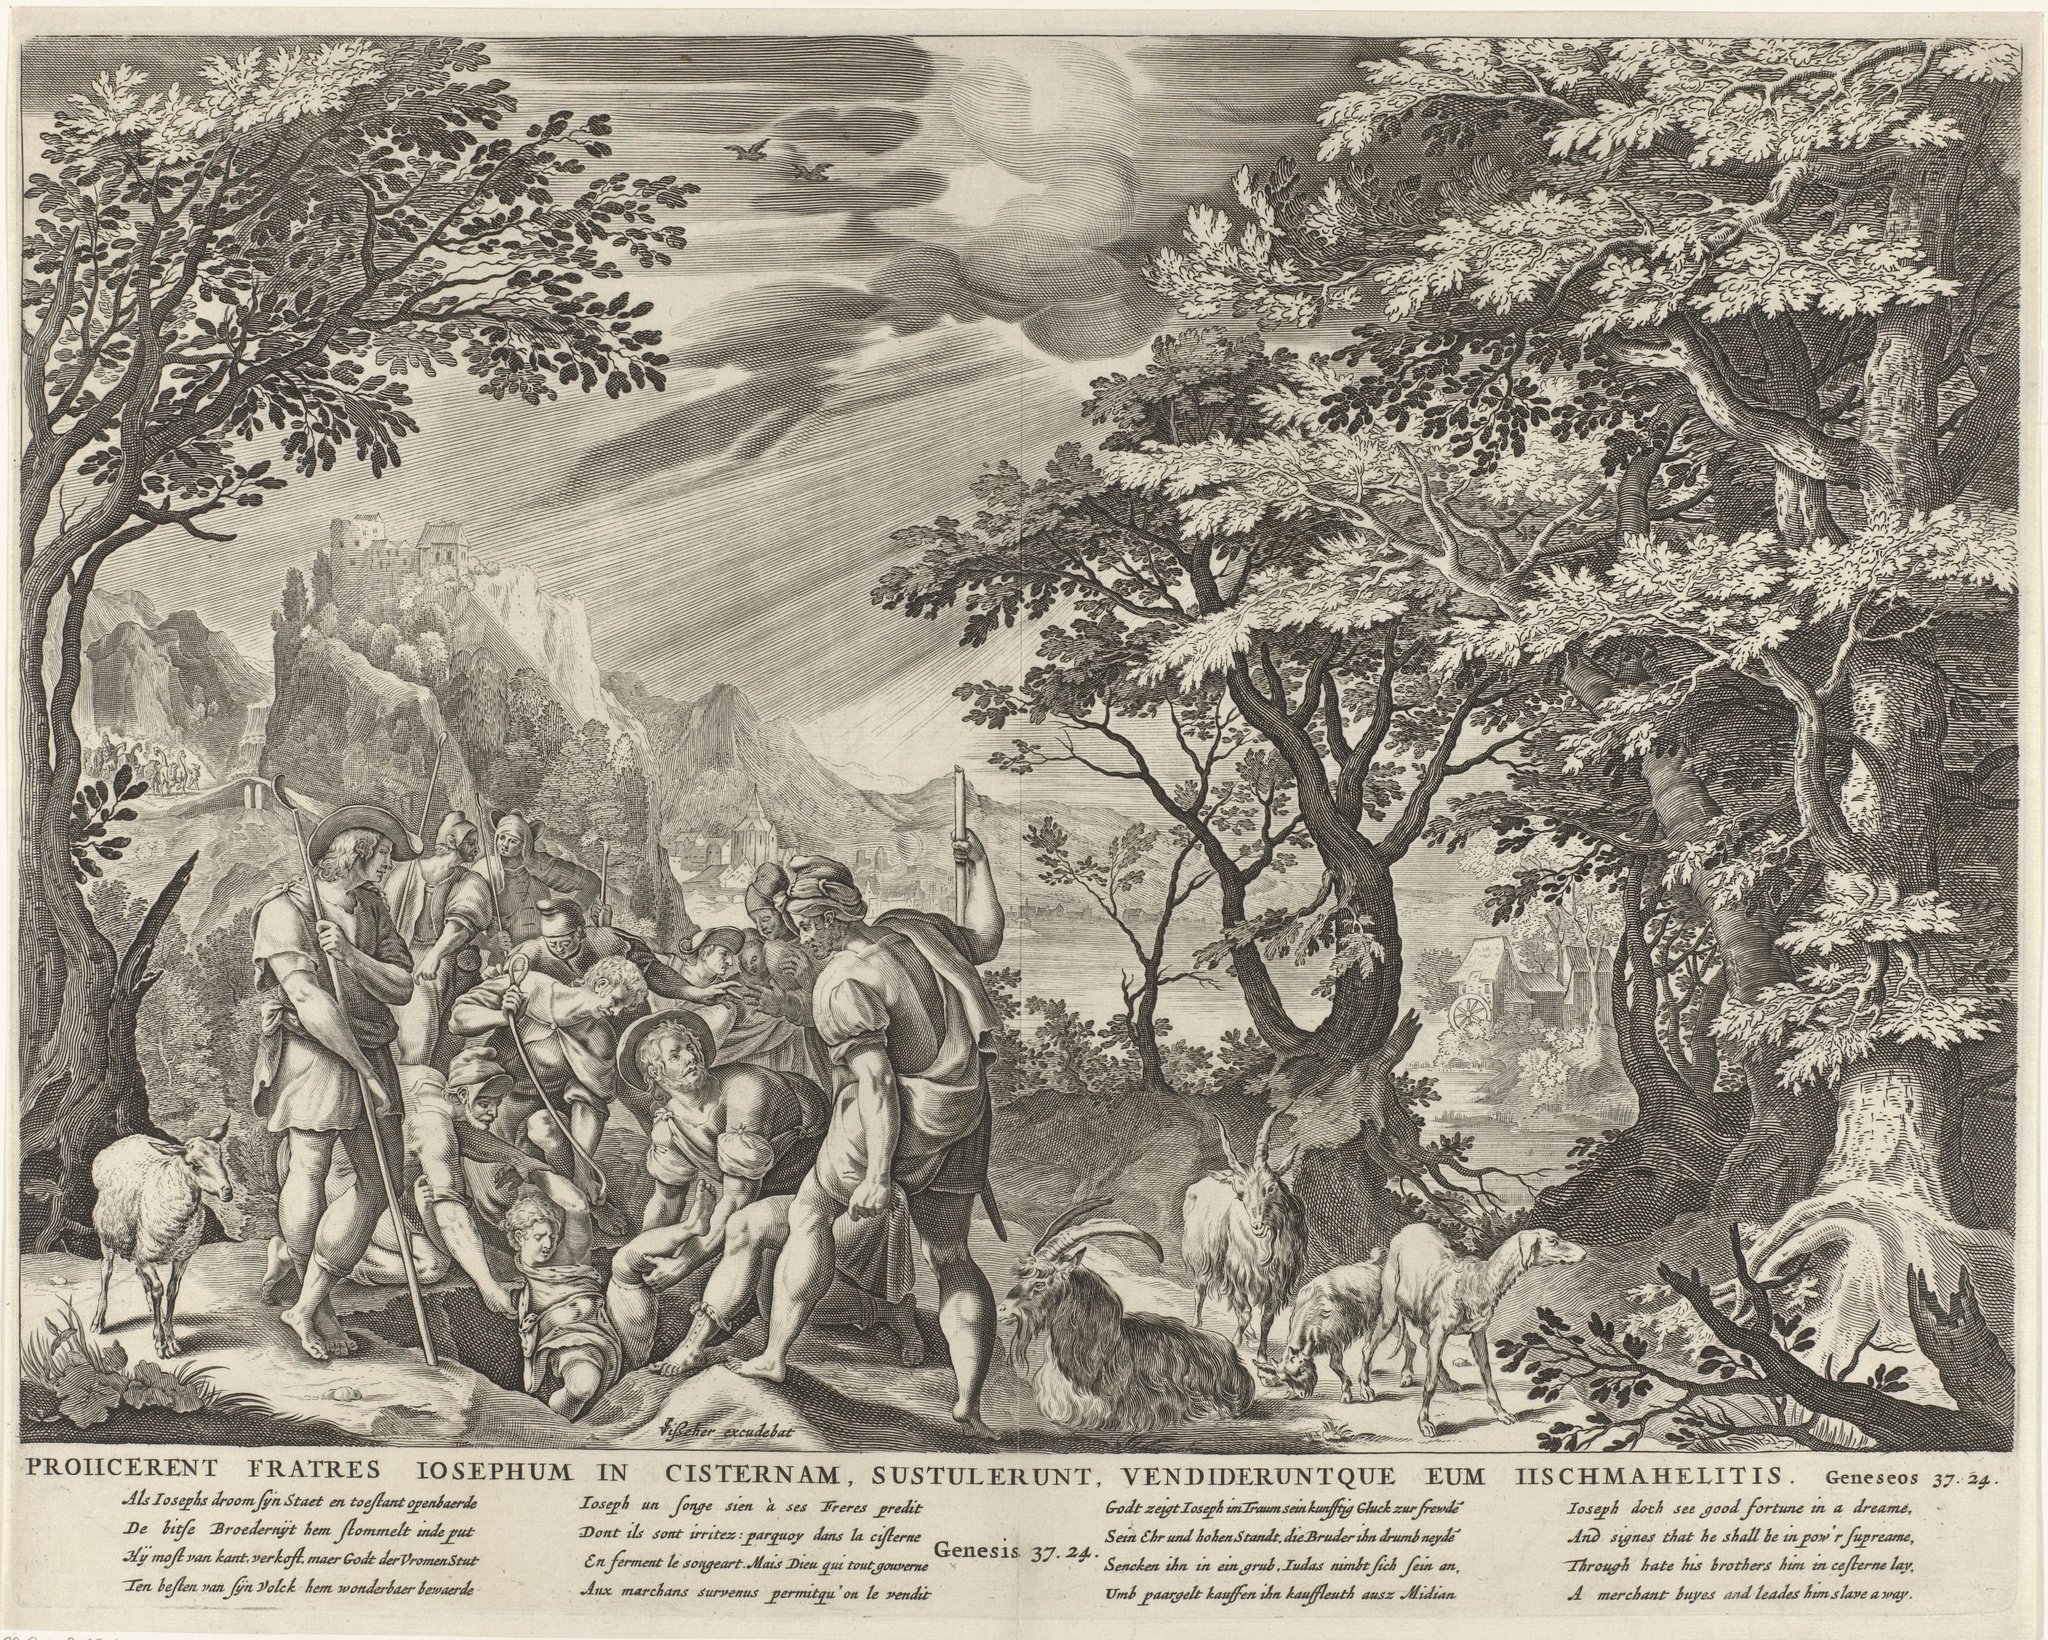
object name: print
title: Royaalbijbel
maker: Anonymous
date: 1630-1652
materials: paper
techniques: engraving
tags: joseph is thrown into a pit (usually depicted as a well or cistern)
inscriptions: collector's mark: Lugt 2228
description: De Amsterdamse uitgever Claes Jansz. Visscher (II) produceerde vanaf de jaren ’30 van de zeventiende eeuw grote Bijbelse prenten op zogenaamd royaal-formaat papier (ca. 480 x 580 mm). Na zijn dood in 1652 zette zijn zoon Nicolaes Visscher (I) het bedrijf voort en zo ook de uitgave van Royaalbijbelprenten. Toen Nicolaes in 1679 overleed nam zijn zoon Nicolaes Visscher (II) het bedrijf over en gaf kort hierna, omstreeks 1680, een fondslijst uit. Hierin worden 130 prenten met Bijbelse voorstellingen op royaalpapier beschreven (zie documentatie J. van der Waals). Complete prentbijbels op royaal-formaat werden door vader en zoon Nicolaes Visscher uitgegeven onder de titel Historiae Sacrae Veteris et Novi Testamenti. De bladen werden echter ook los verkocht en konden worden gecombineerd met Royaalbijbel-prenten van andere uitgevers. Verschillende Amsterdamse uitgevers brachten namelijk ook bijbelprenten op royaal-formaat uit, onder wie Clement de Jonghe en Cornelis Danckerts. De door de firma Visscher uitgegeven prenten zijn veelal vervaardigd door anonieme prentmakers naar voorbeeld van verschillende zestiende- en zeventiende-eeuwse Bijbelse prenten en prentreeksen. Veelal moesten de composities worden aangepast aan het grotere en langgerekte royaal-formaat. Daarnaast zijn er ook grote bladen van bekende prentmakers zoals Jan van Londerseel, Pieter Nolpe, Jacques de Gheyn (II) en Jan Harmensz. Muller opgenomen in de categorie ‘Bybelsche Figuren, op Royaal-bladen’ in de fondslijst van Visscher. Prent mogelijk gebruikt in: Historiae Sacrae Veteris et Novi Testamenti (Royaalbijbel). Amsterdam: Nicolaes Visscher (I) en (II), [1652-1702]. In de fondslijst van Nicolaes Visscher II (ca. 1680) is het onderwerp van deze prent onder de titel 'Bybelsche Figuren, op Royaal-bladen. bestaande uyt de volgende historien.' als volgt genummerd: 20. De groep mensfiguren naar een prent van Sadeler naar ontwerp van de Vos. Schaap, geiten en hond naar prenten van Berchem.